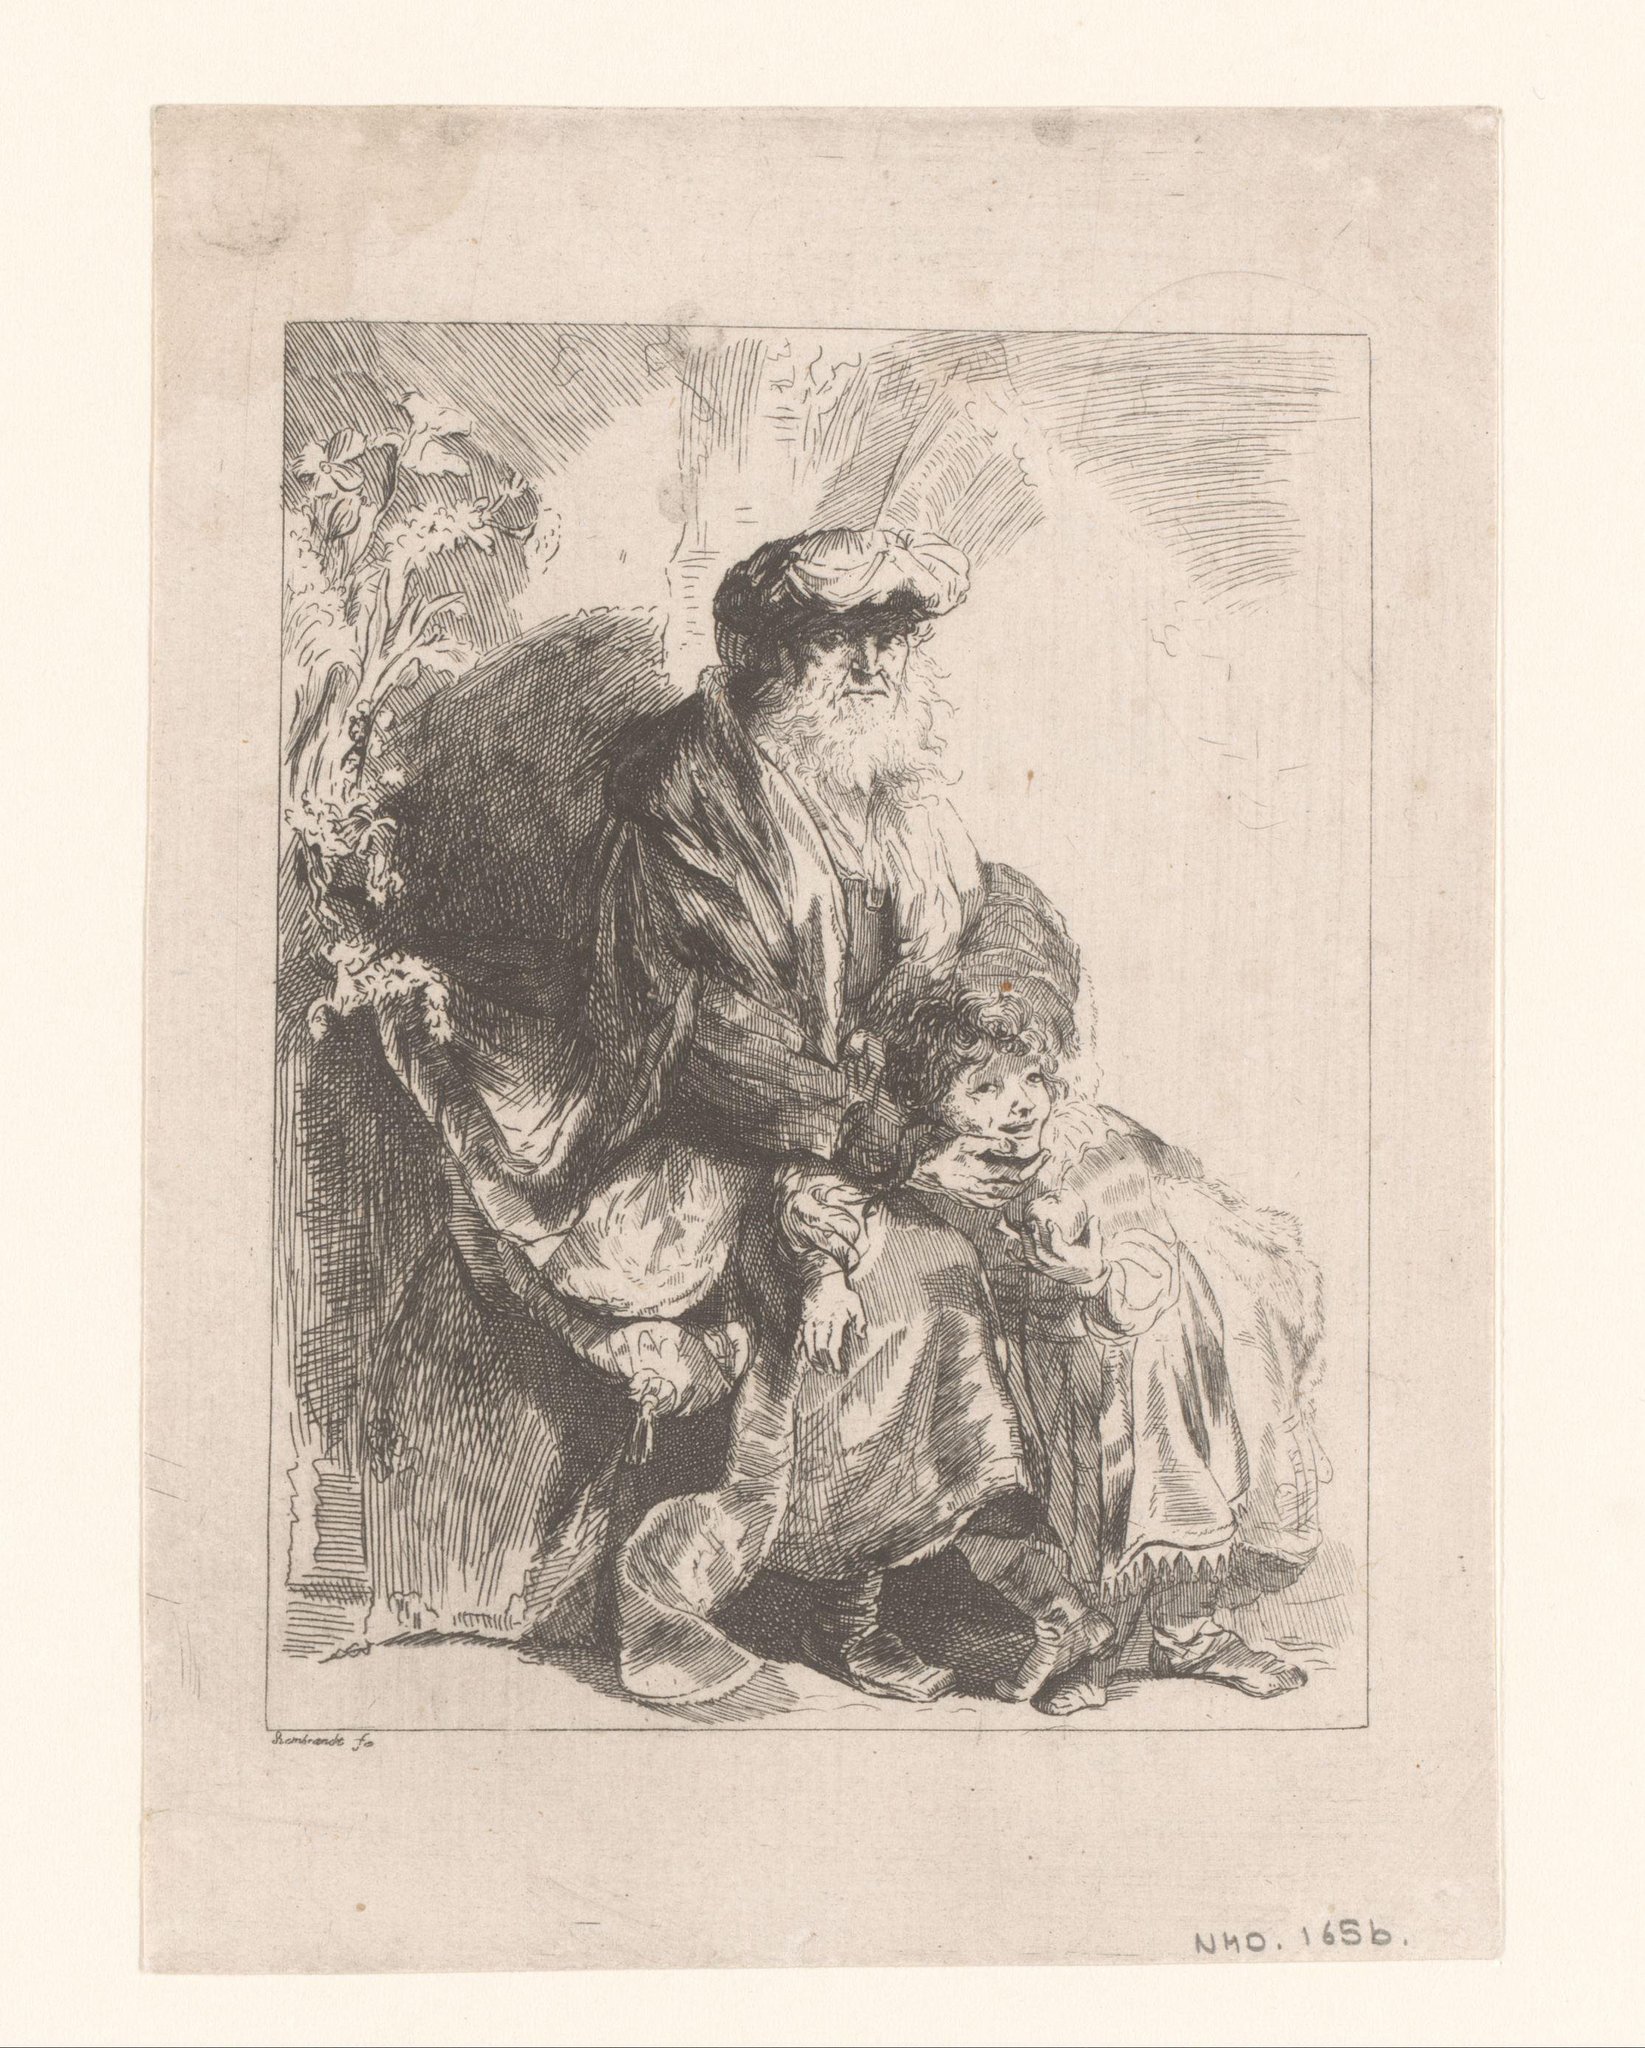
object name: print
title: Abraham caressing Isaac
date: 1637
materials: paper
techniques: etching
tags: story of abraham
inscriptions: collector's mark: Lugt 4071, collector's mark: Lugt 2760, collector's mark: Lugt 2228